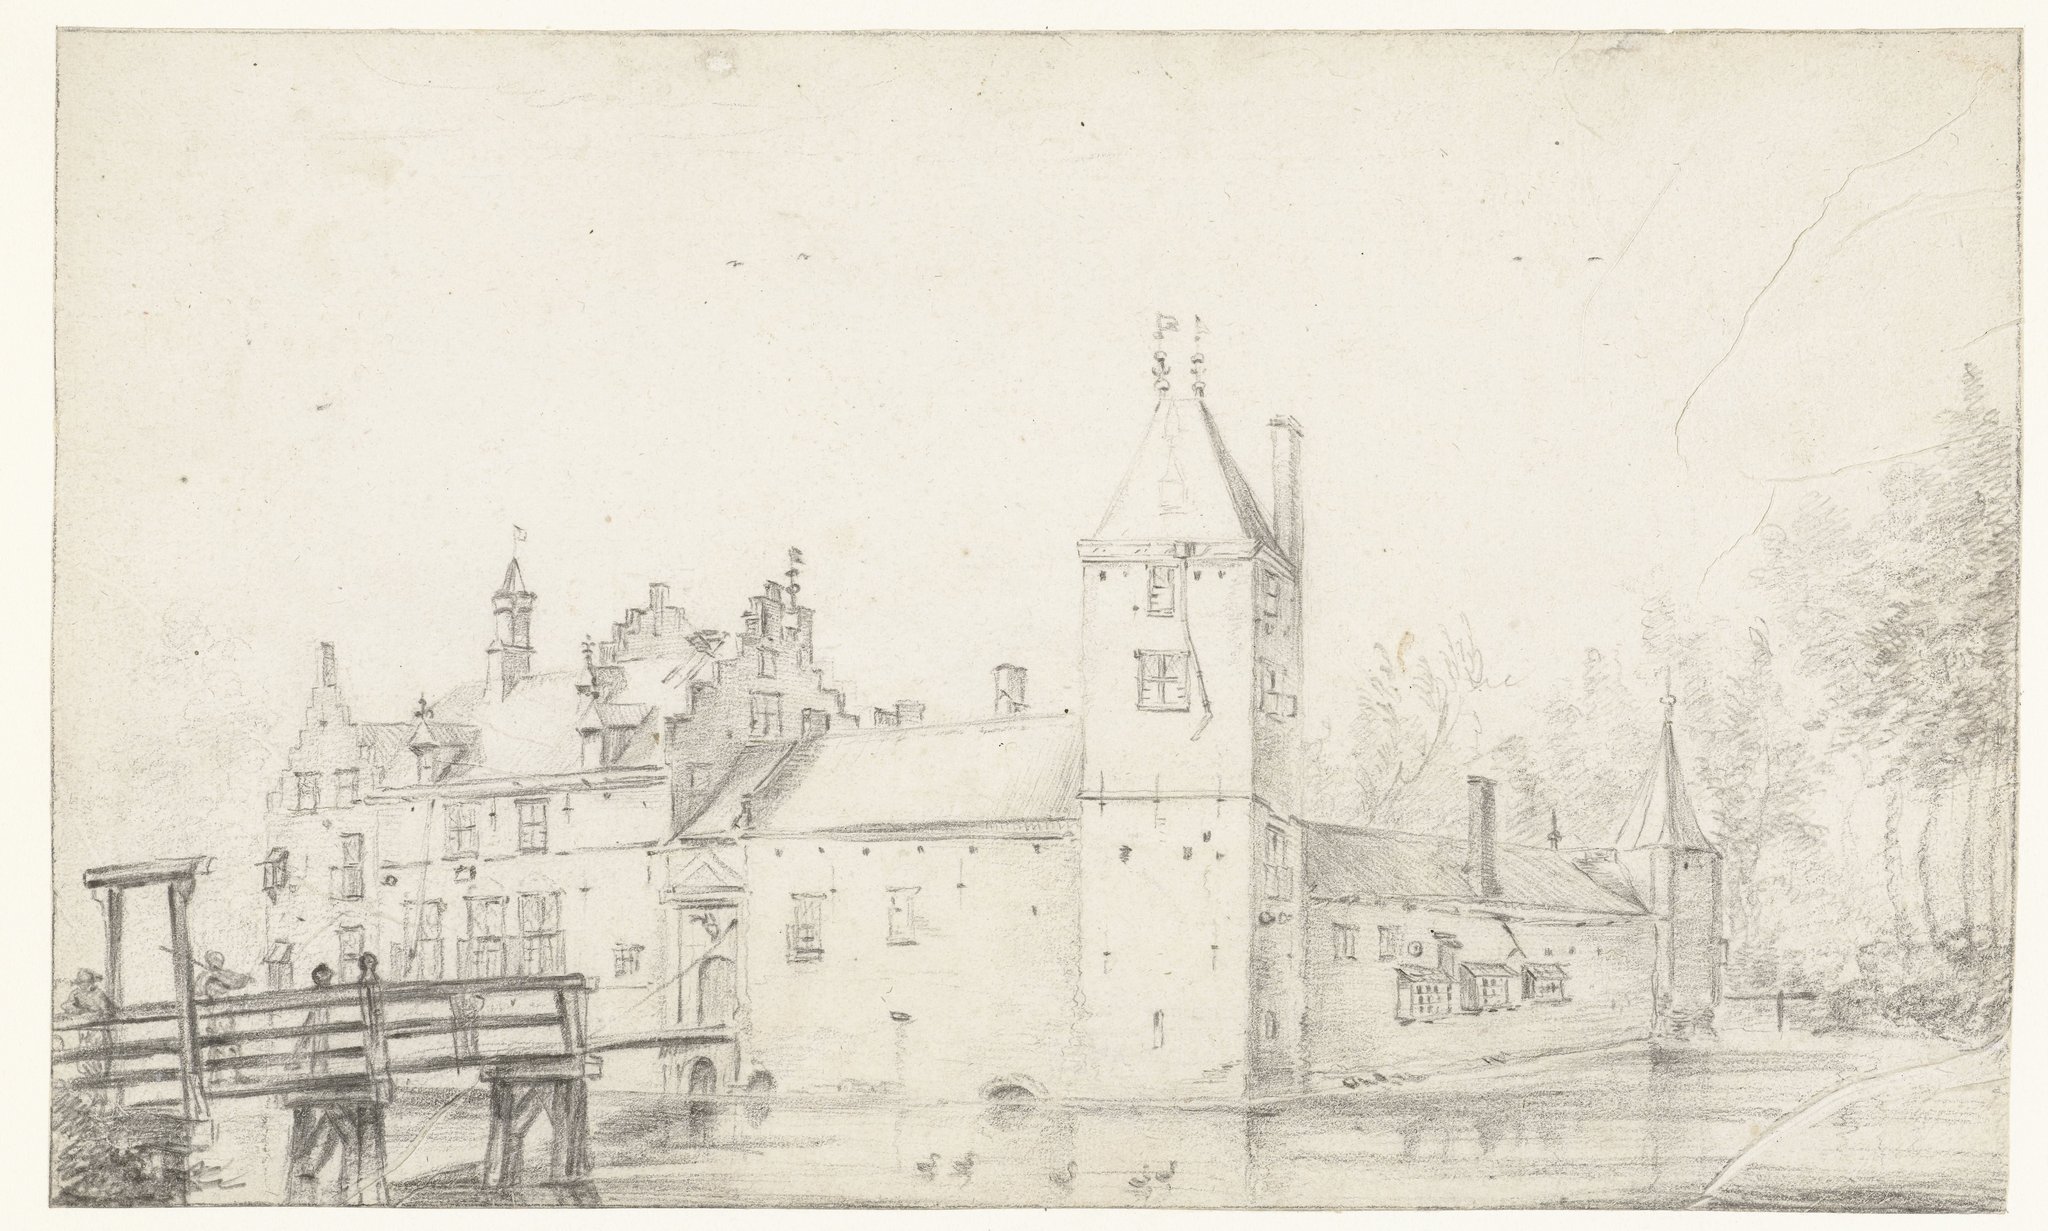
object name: drawing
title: Lokhorst oftewel Oud-Teilingen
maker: roelant roghman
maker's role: draughtsman, painter, print maker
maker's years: 1627-1692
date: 1646-1650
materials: chalk, paper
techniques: pouncing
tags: castle